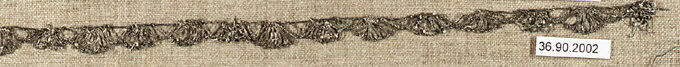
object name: piece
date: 1701-1800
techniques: lace